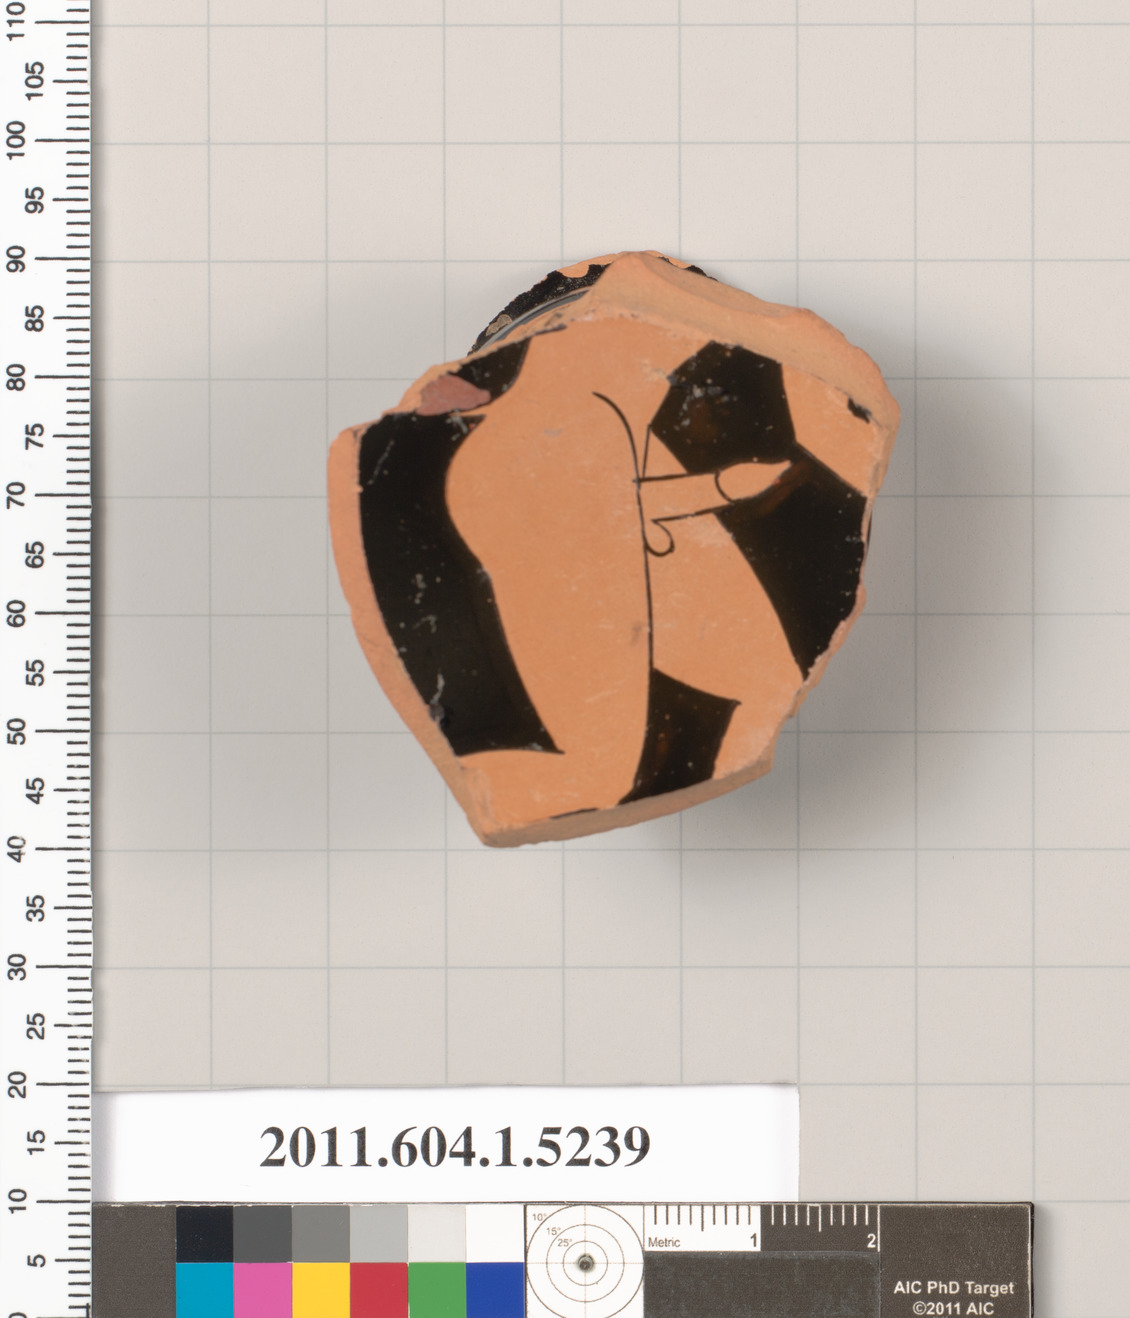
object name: kylix fragment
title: Terracotta fragment of a kylix (drinking cup)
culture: greek, attic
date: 520-500 BCE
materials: terracotta